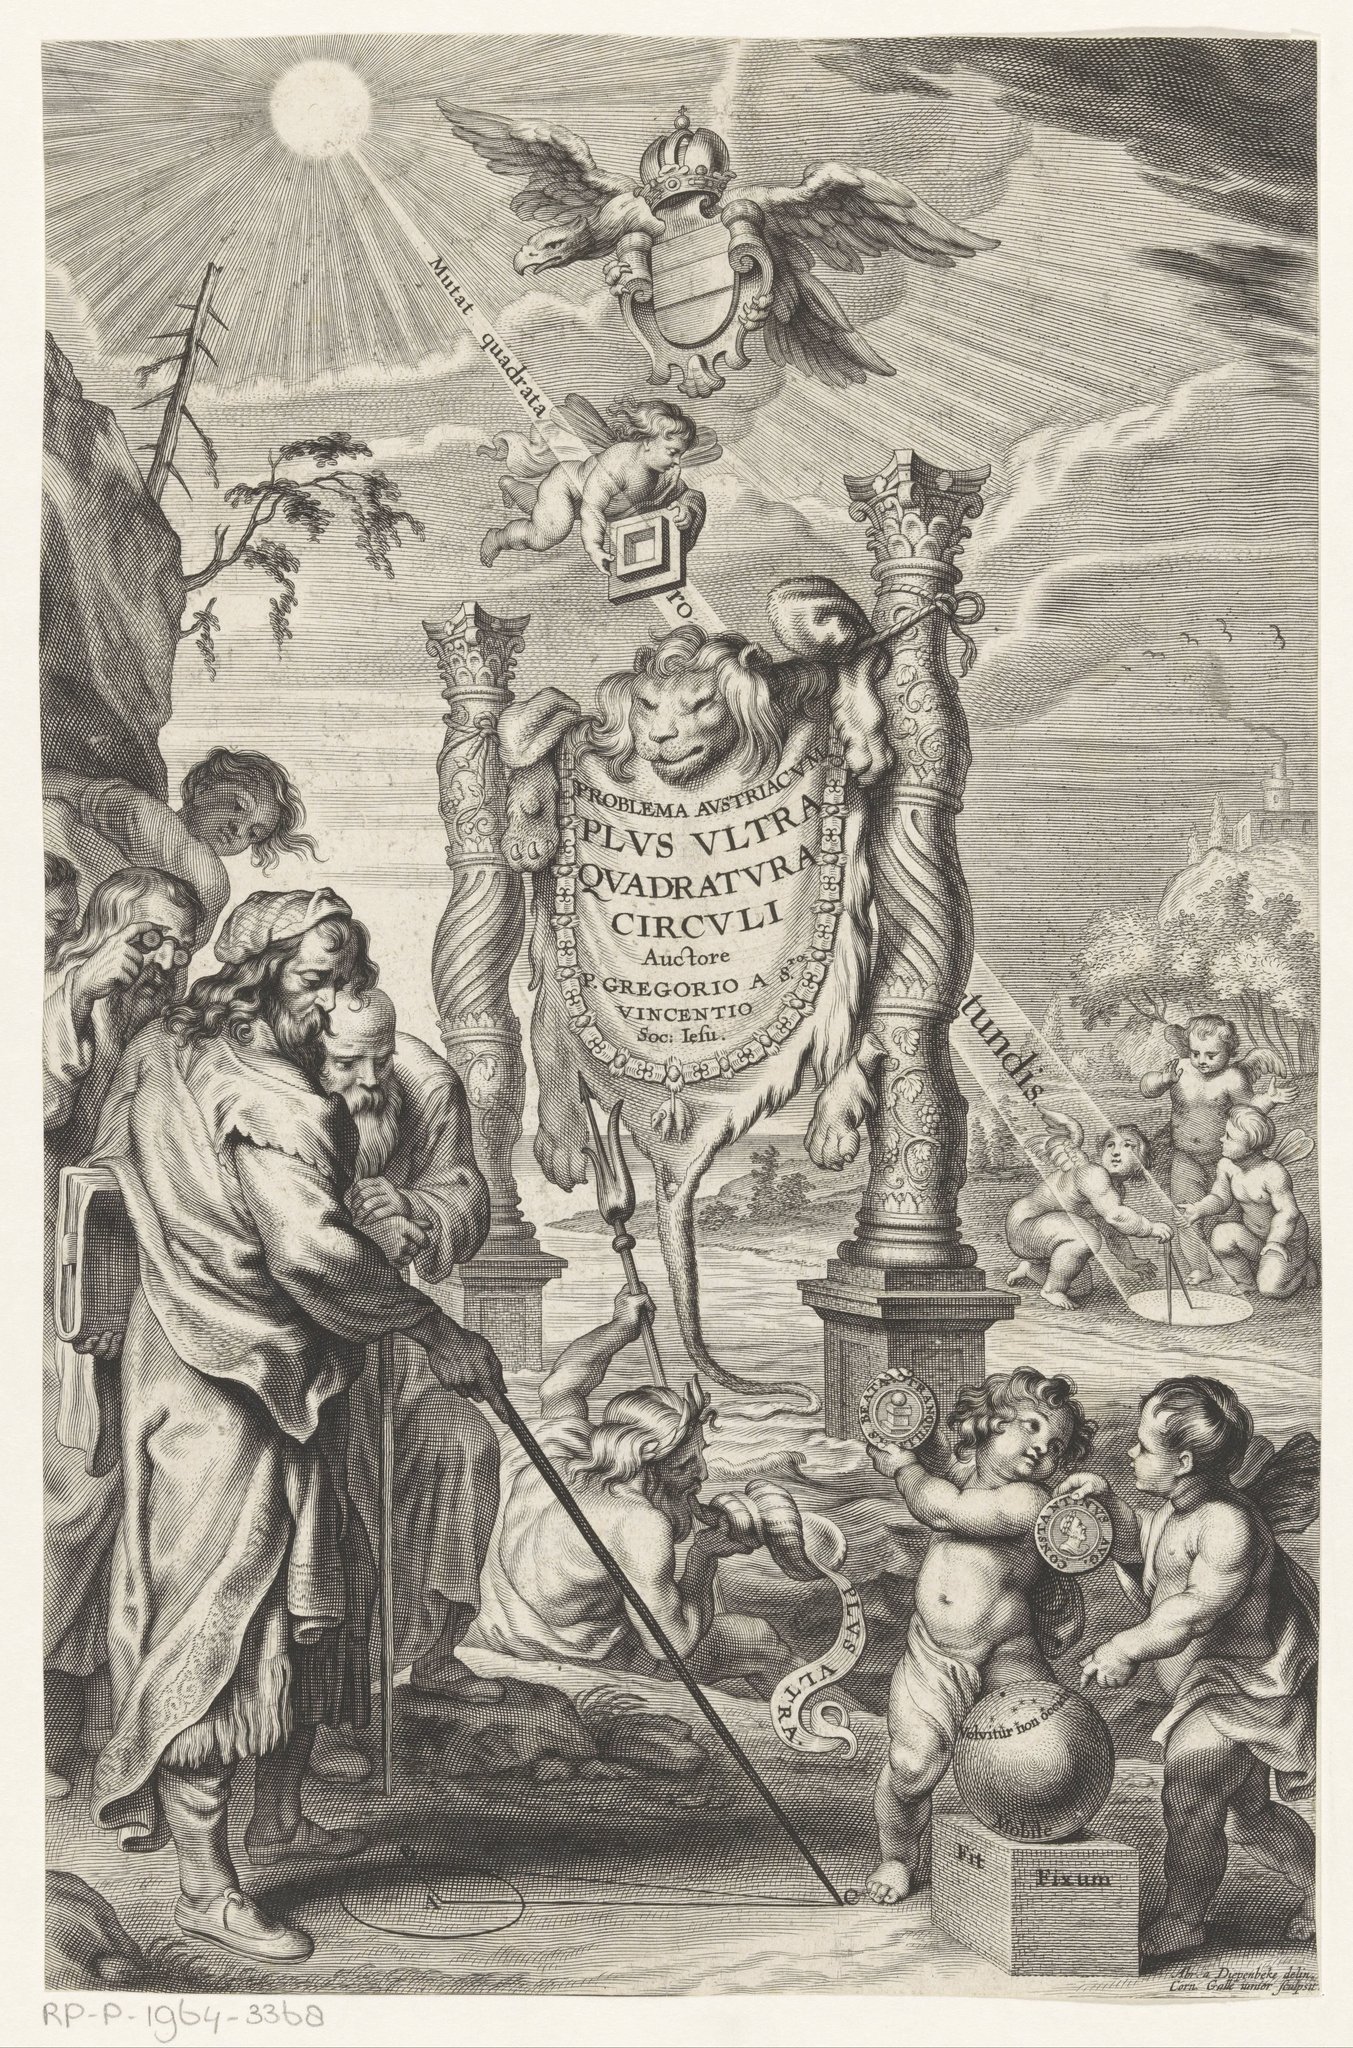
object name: print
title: Titelpagina voor: Gregorius à Sancto Vincentio, Problema Austriacum plus ultra quadratura circuli , 1647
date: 1647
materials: paper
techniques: engraving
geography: antwerp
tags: drawing, measuring, calculating, cupids: 'amores', 'amoretti', 'putti'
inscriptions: collector's mark: ‘Bibliotheqe royale de Belgique / Double échangé on vendu’, collector's mark: Lugt 2760, collector's mark: Lugt 2228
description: Tussen twee zuilen is een leeuwenhuid gespannen met de titel van het boek. Een man tekent met een stok een cirkel en een driehoek in het zand. Twee mannen achter hem kijken ernaar. Rechts twee putti die medailles tonen, achter drie putti die met een passer een cirkel tekenen.